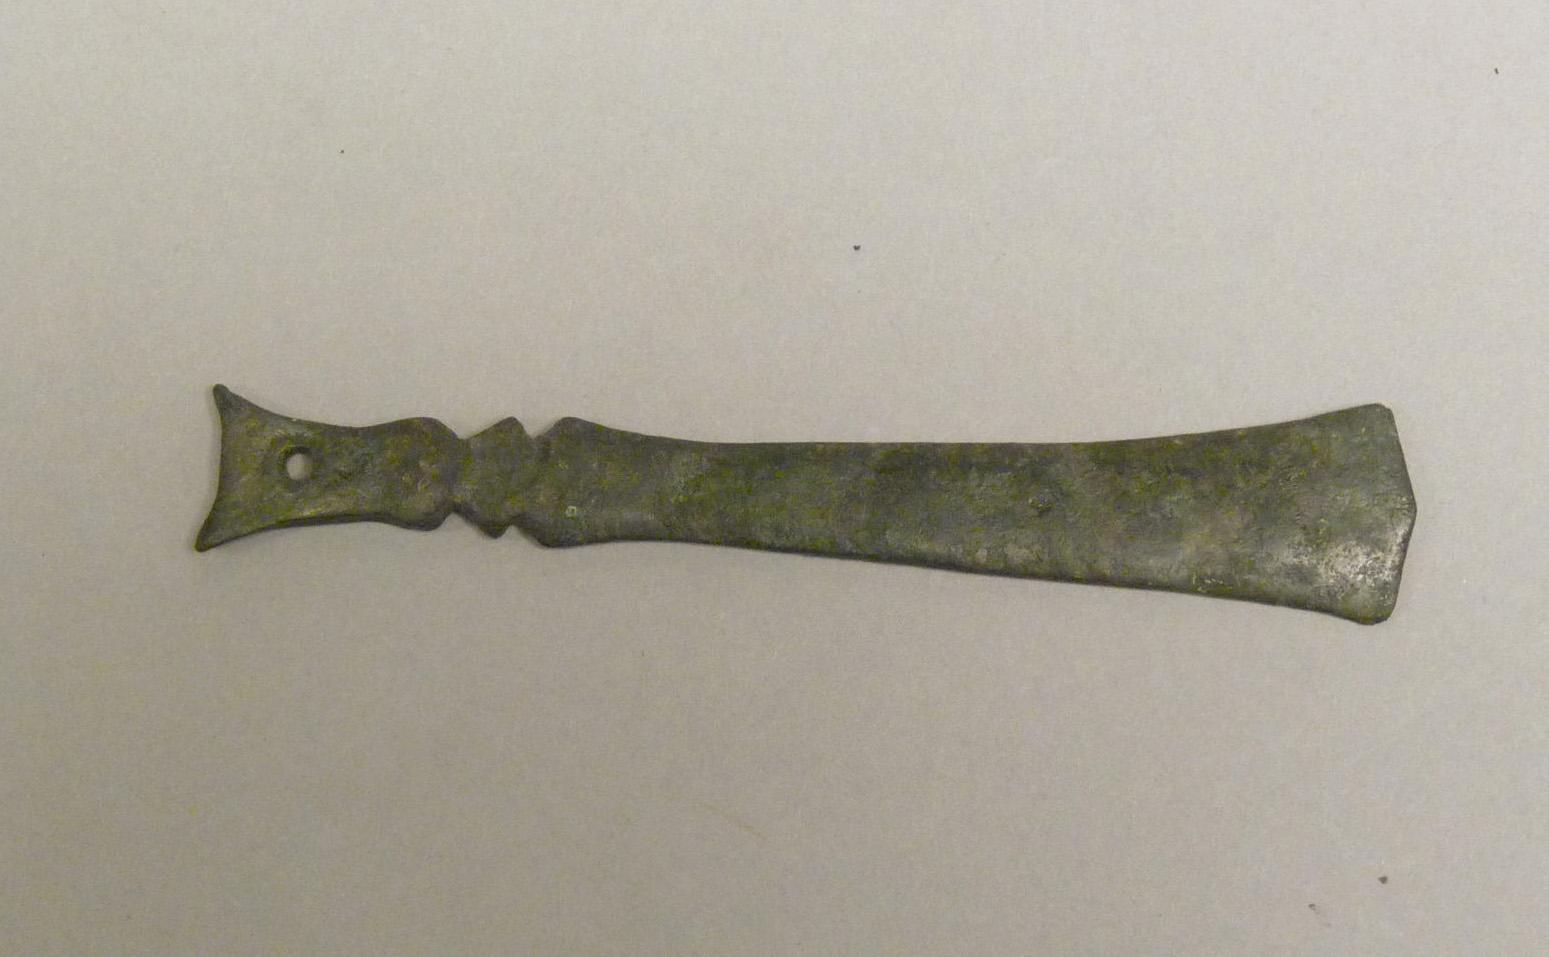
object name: spatula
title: Sword-Shaped Lime Spatula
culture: indonesian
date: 500 BCE-300 CE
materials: bronze